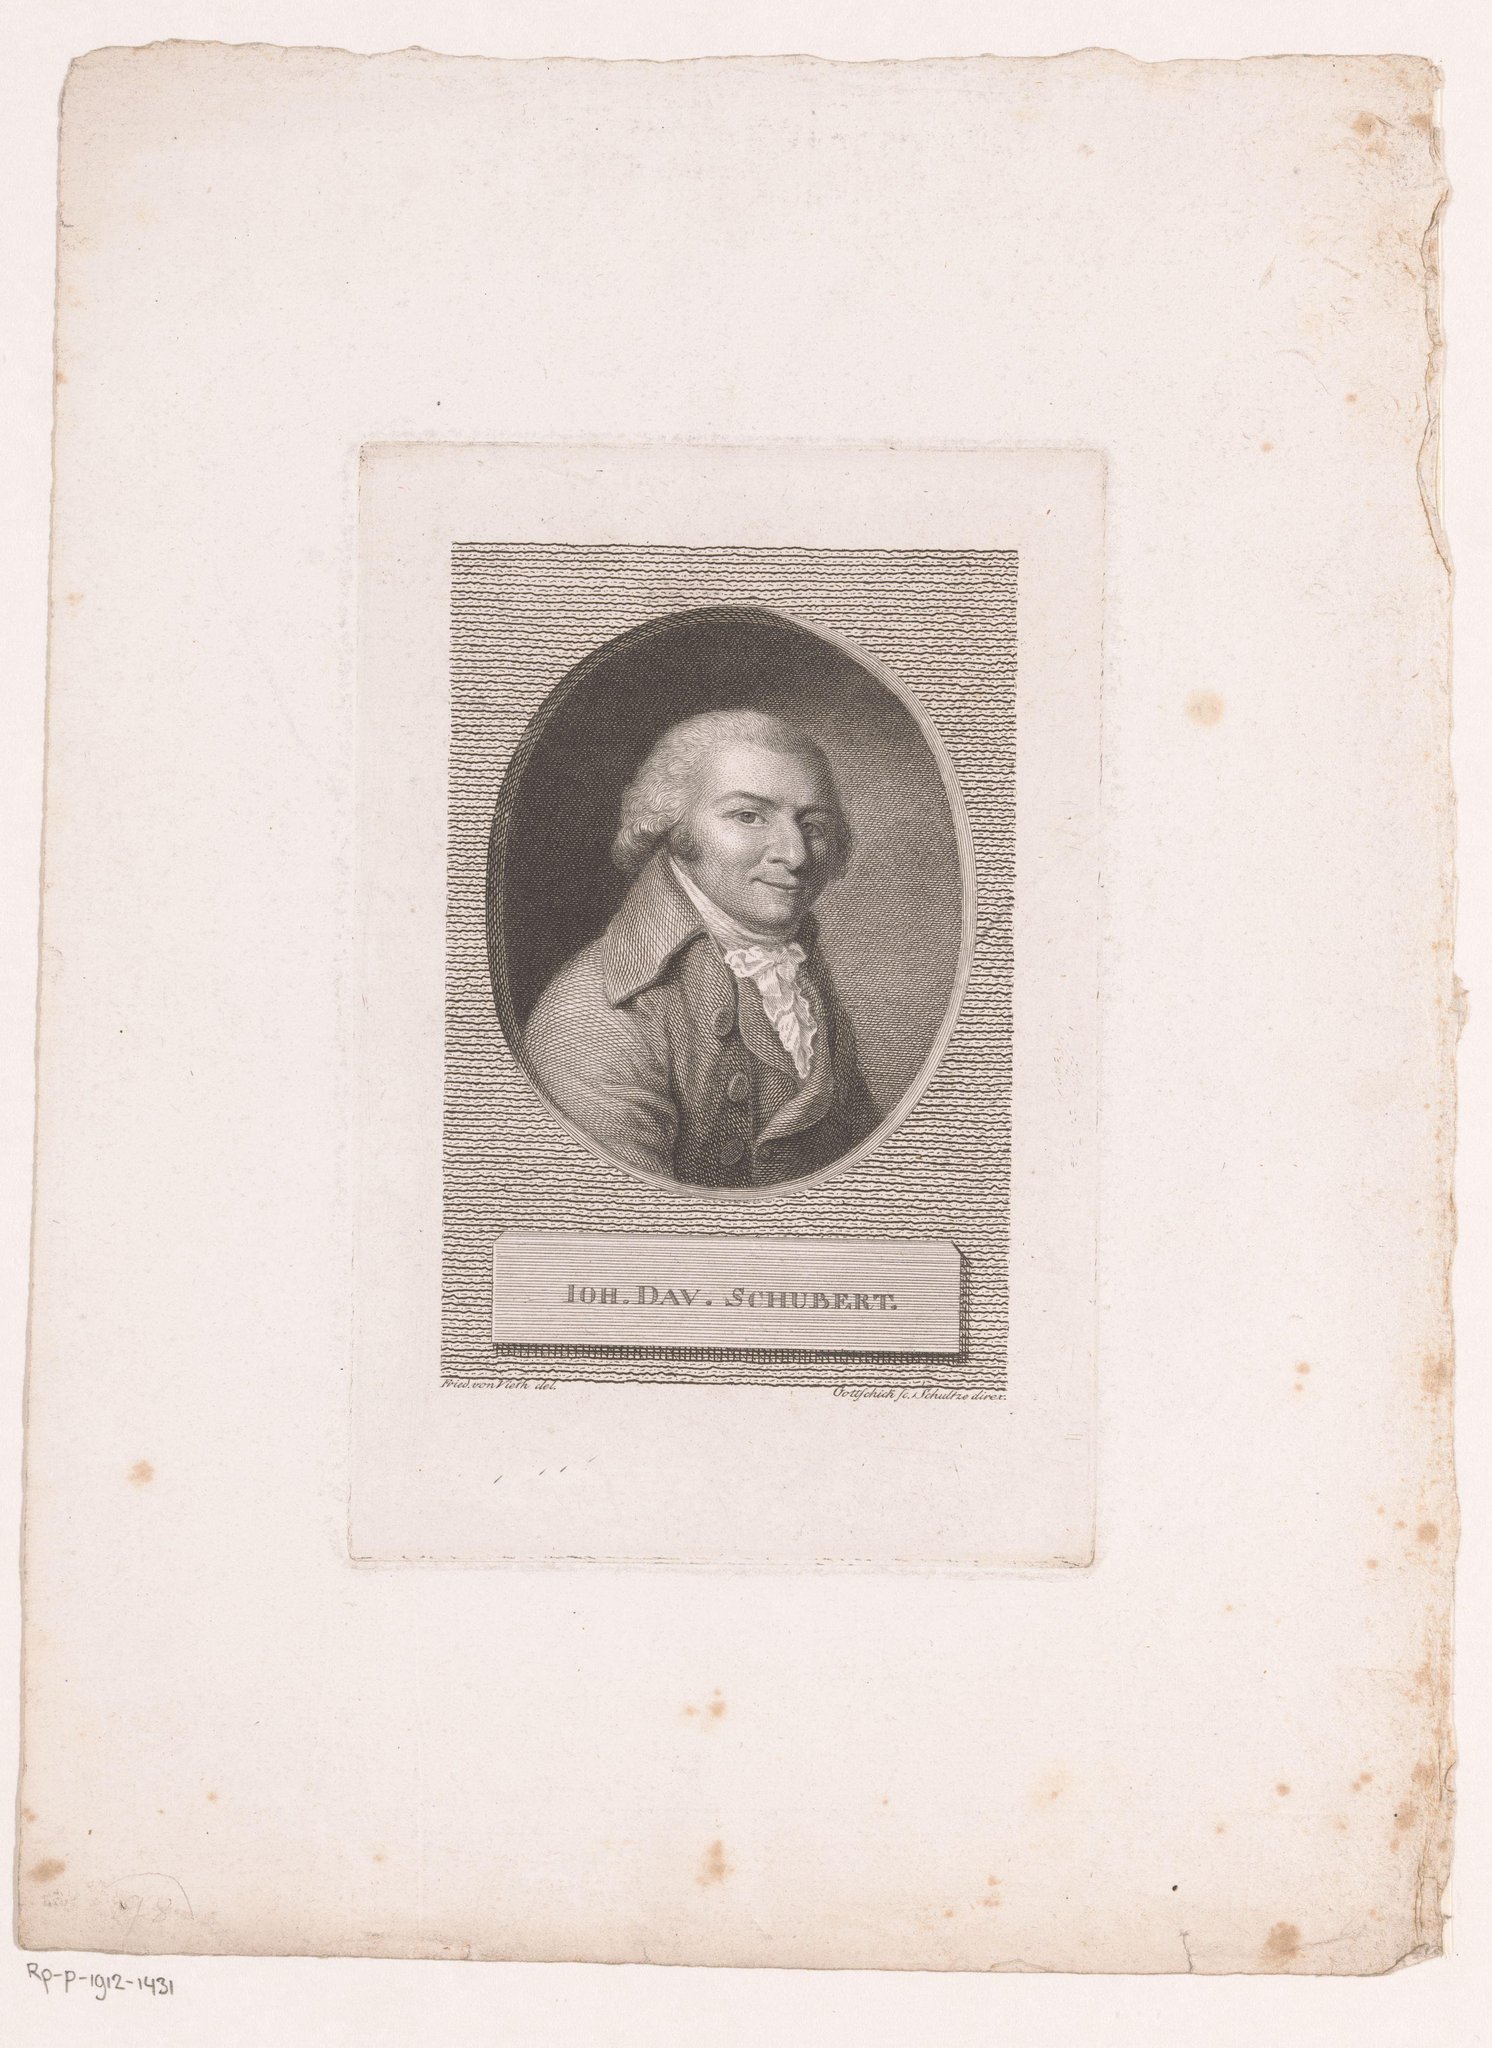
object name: print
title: Portret van Johann David Schubert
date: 1795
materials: paper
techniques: engraving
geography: leipzig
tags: painter, draughtsman, historical persons, portrait, self-portrait of artist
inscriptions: collector's mark: Lugt 2228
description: Prent gebruikt voor: Neue Bibliothek der schönen Wissenschaften und der freyen Künste. Leipzig: Johann Gottfried Dyck, 1795, dl. 55.